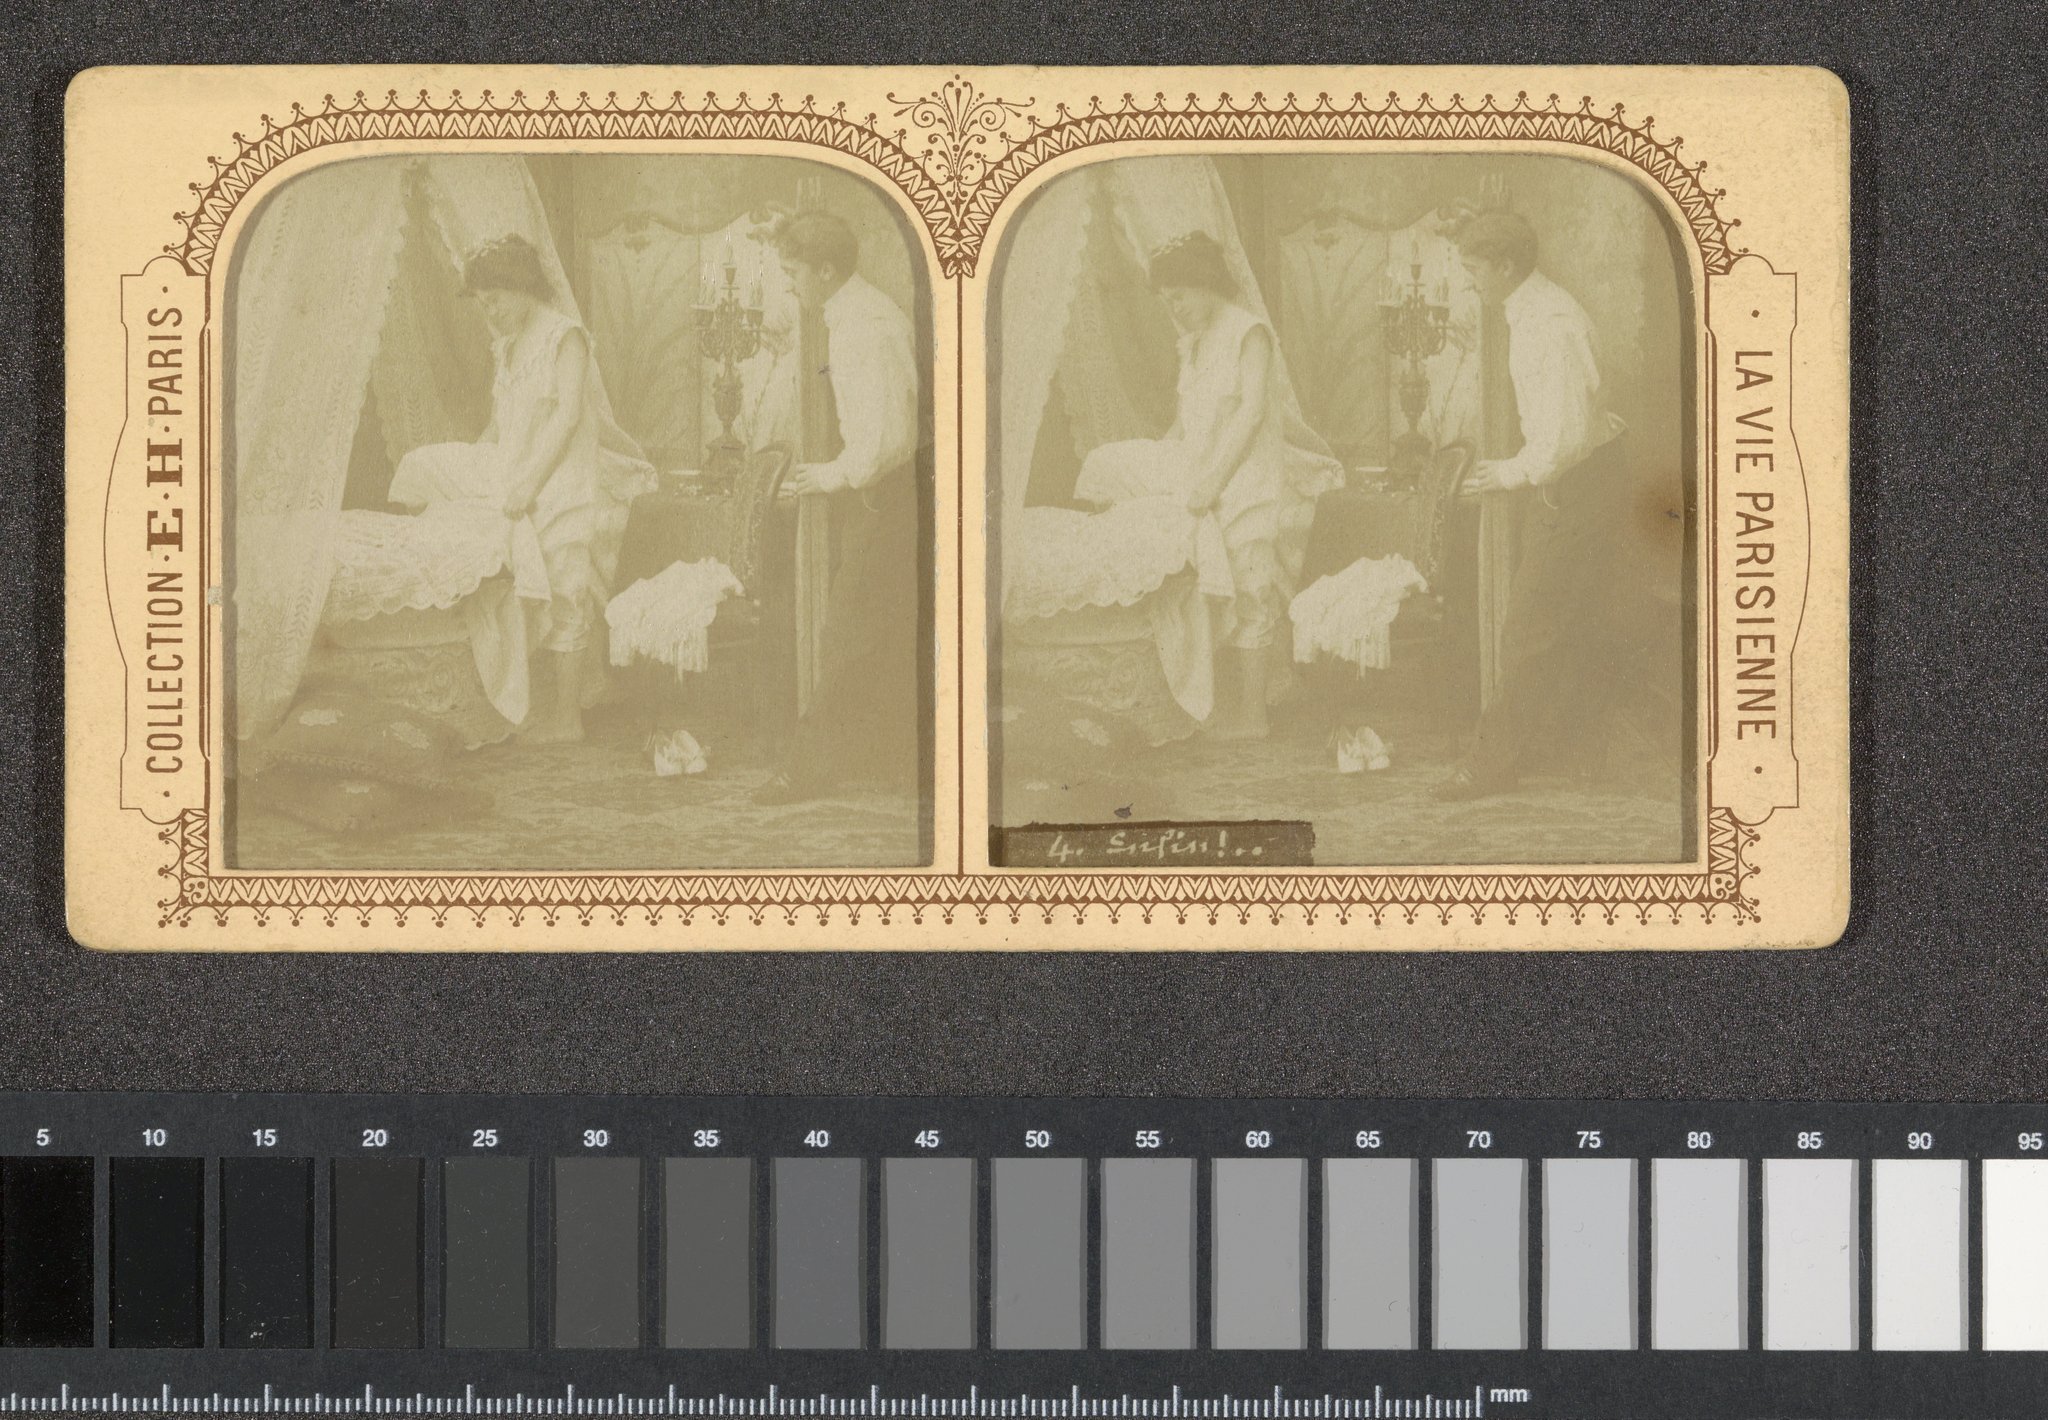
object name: stereograph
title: Scènes de la vie parisienne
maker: eugène hanau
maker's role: publisher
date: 1870-1890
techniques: albumen print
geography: paris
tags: 42d262